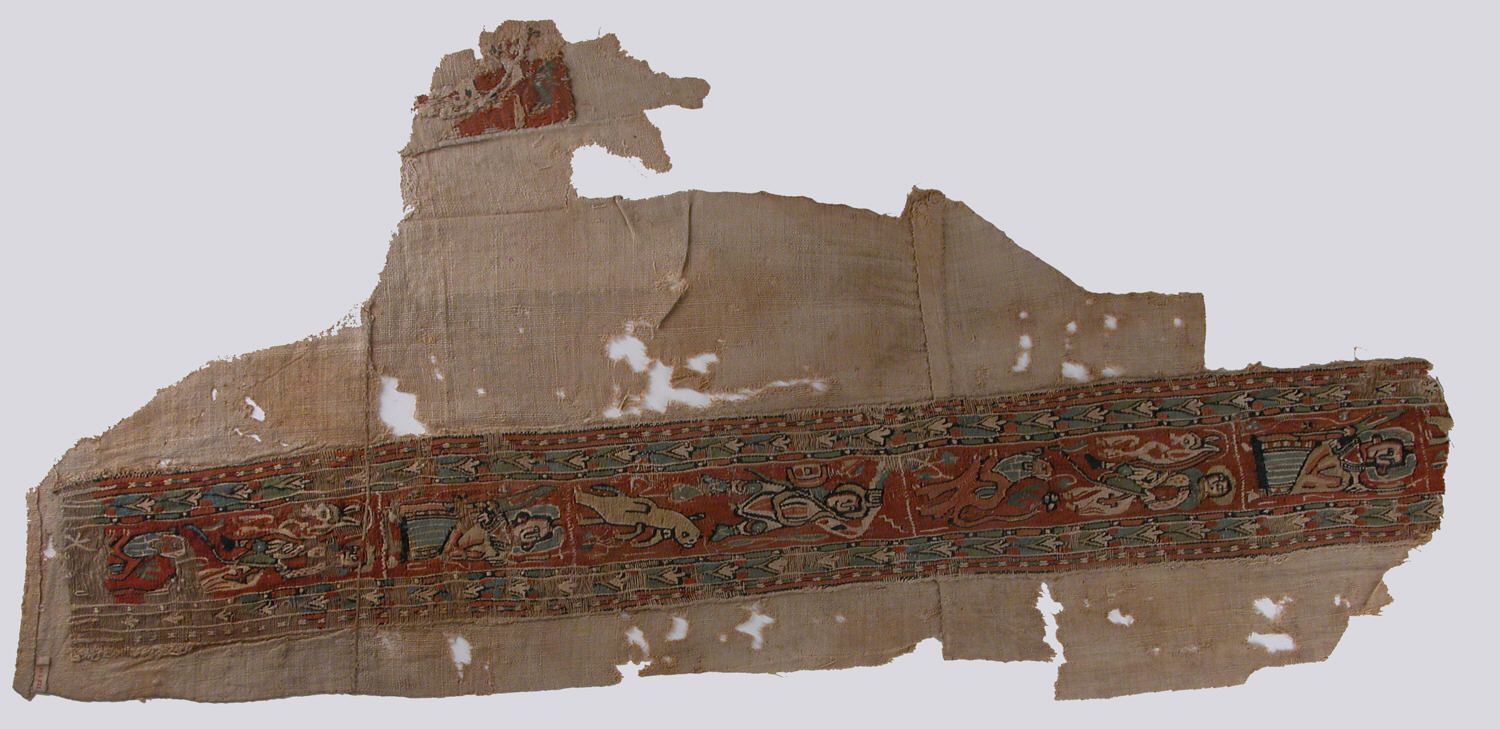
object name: band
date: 501-700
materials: linen, wool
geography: egypt